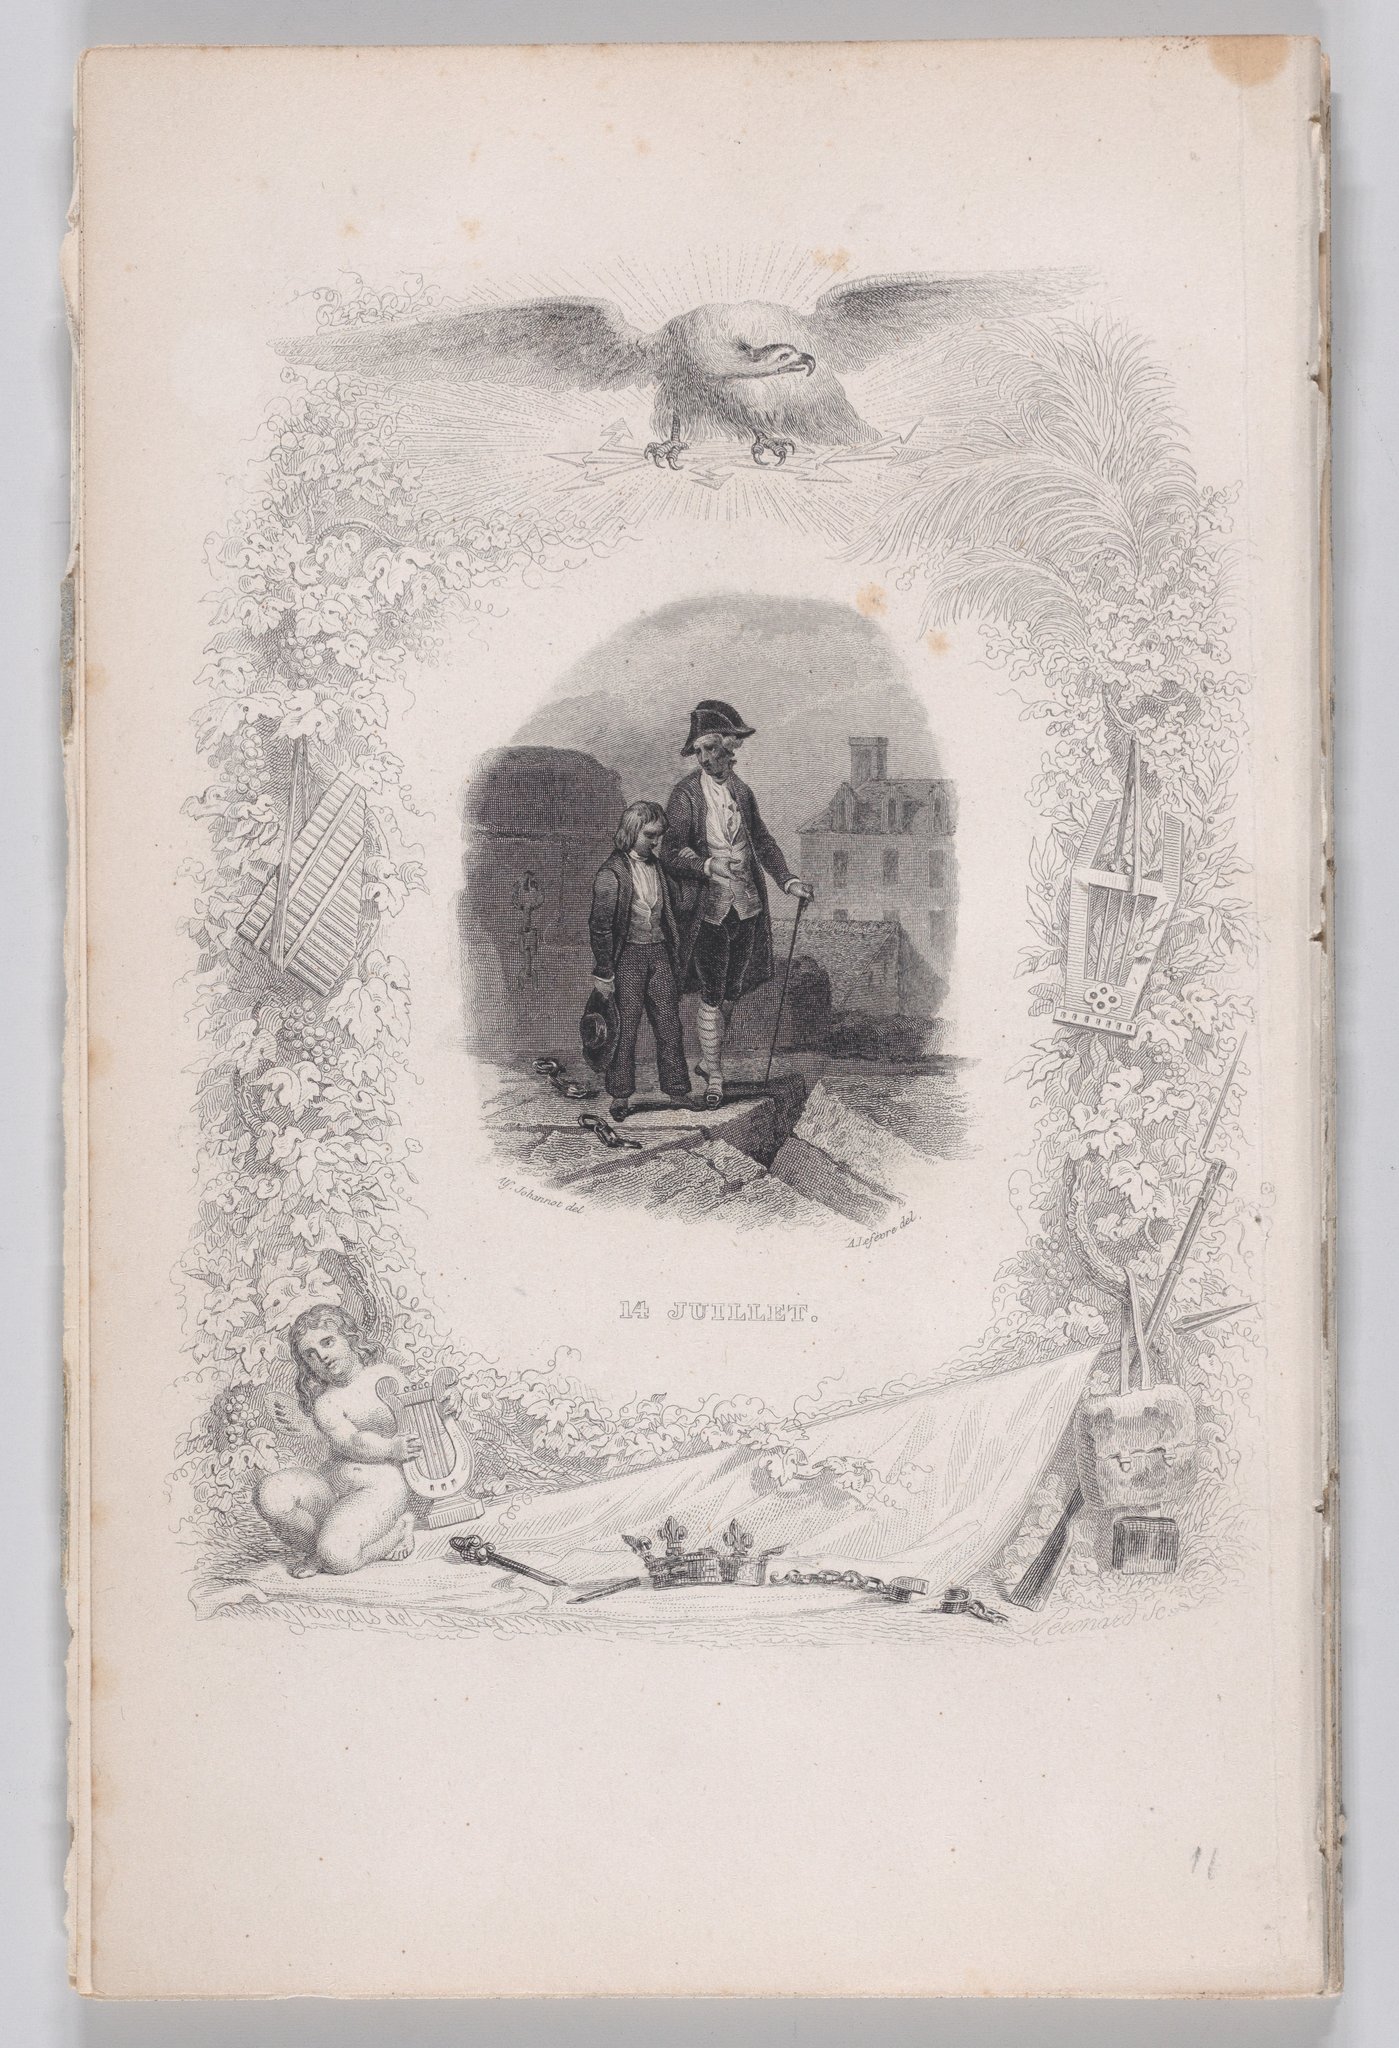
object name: print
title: July Fourteenth, from "The Complete Works of Béranger"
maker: alfred johannot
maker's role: designer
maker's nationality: french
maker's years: 1800-1837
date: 1829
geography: paris